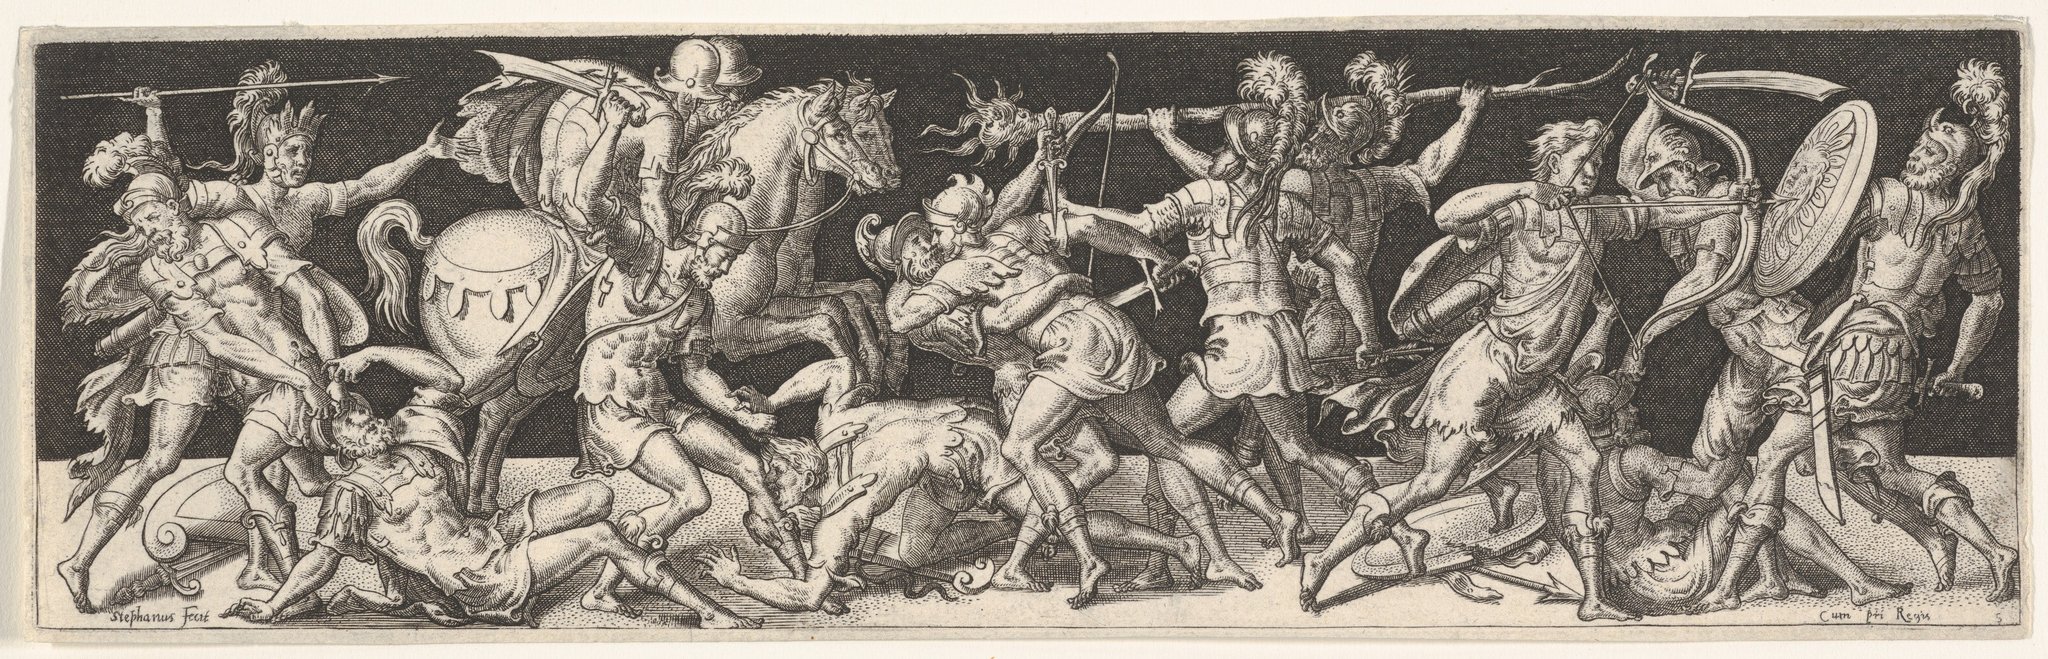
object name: print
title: Plate from "Battles and Victories" (Combats et Triomphes)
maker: etienne delaune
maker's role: artist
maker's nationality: french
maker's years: 1518-1583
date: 1540-1583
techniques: engraving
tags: battles,soldiers,weapons,horses